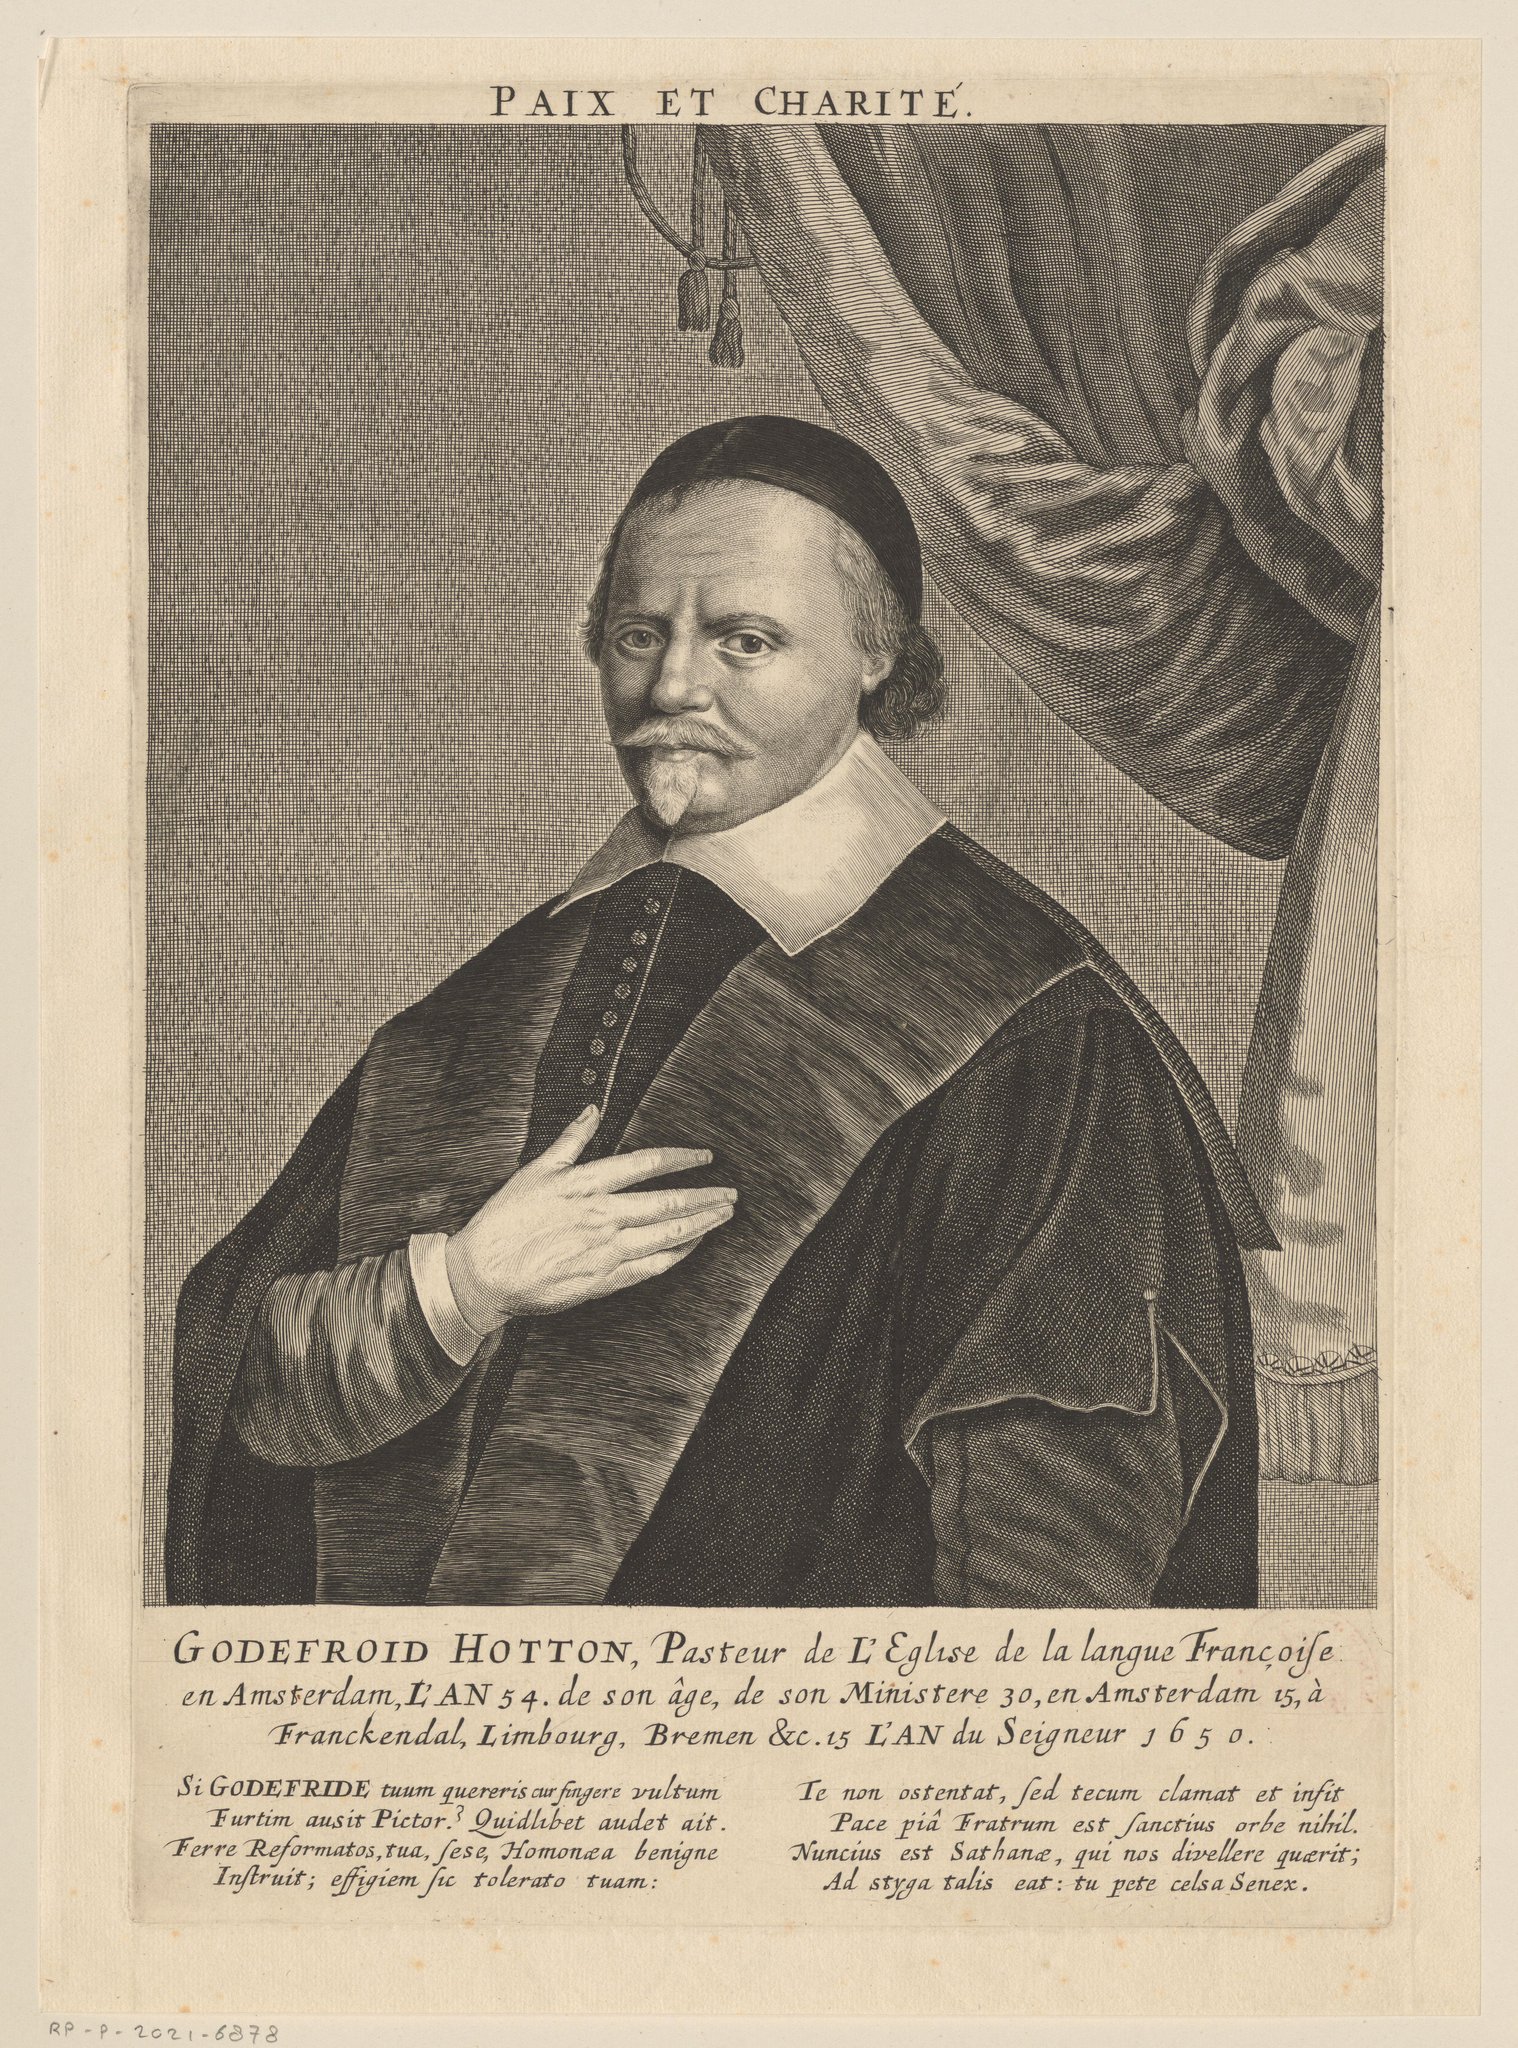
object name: print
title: Portret van Godefroid Hotton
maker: Anonymous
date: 1650-1674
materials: paper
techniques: engraving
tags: historical persons, functionaries and dignitaries ~ episcopal protestant churches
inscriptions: collector's mark: Lugt 240